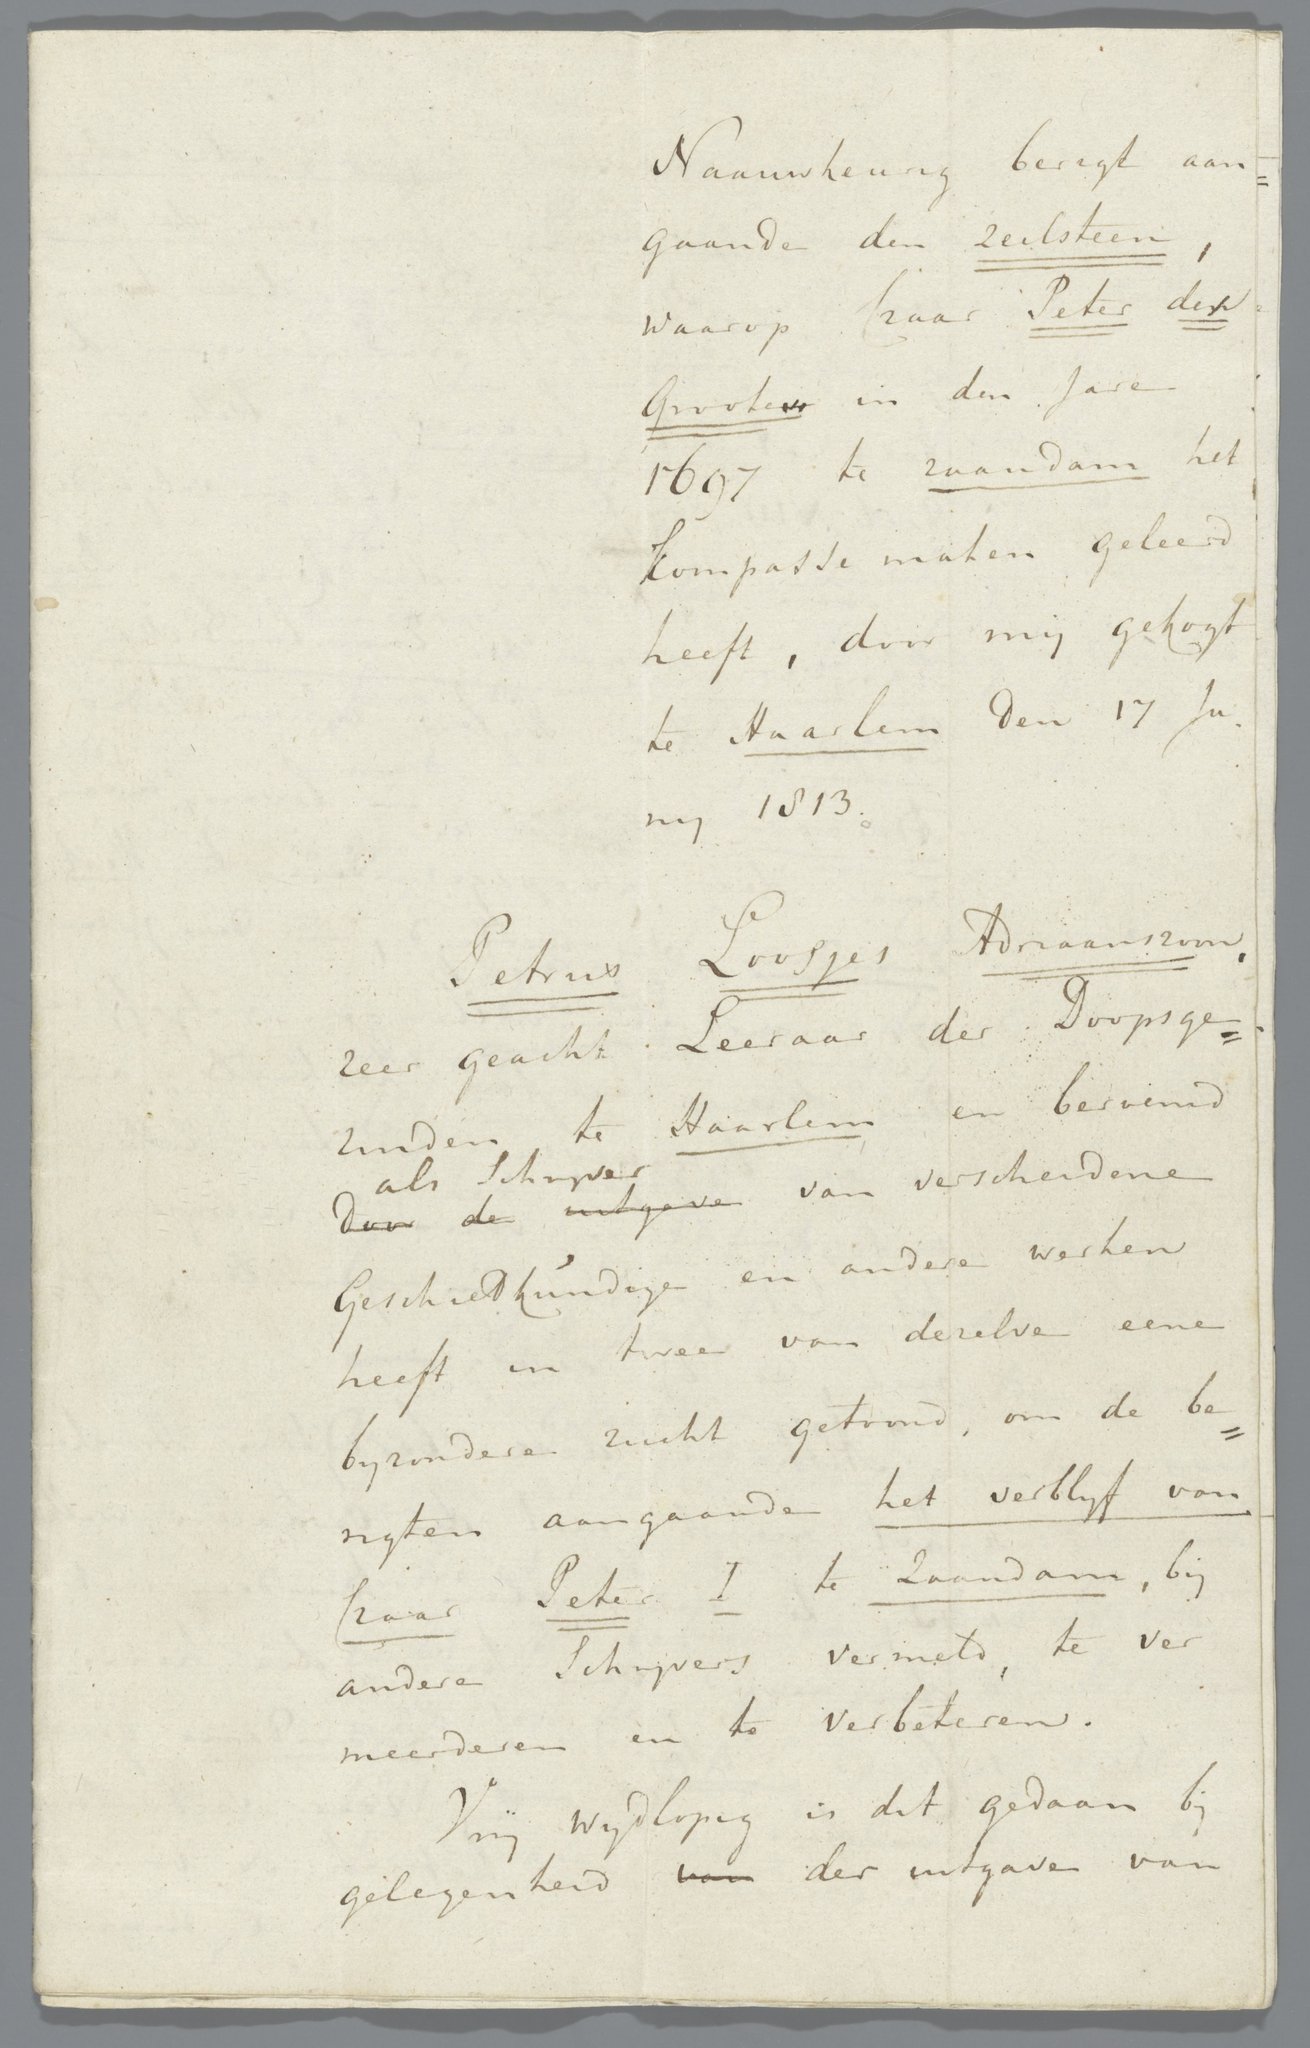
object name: verklaring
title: Verklaring van J. Scheltema betreffende de herkomst van de zeilsteen van Tsaar Peter de Grote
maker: jacobus scheltema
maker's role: geschiedschrijver, letterkundige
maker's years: 1767-1835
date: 1813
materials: ink, lacquer, paper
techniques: printing, folding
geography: zaandam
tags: peter i de grote (tsaar van rusland)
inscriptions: date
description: Handgeschreven verklaring op 3 vellen papier, in elkaar gevouwen zodat er 12 bladzijden ontstaan, waarvan er 10 beschreven zijn. Op pagina10 bij de signatuur een zegelstempel. Opschrift: Naauwkeurig berigt aan / gaande den zeilsteen, / waarop Czaar Peter den / Grooten in den Jaren / 1697 te Zaandam het / kompassemaken geleerd / heeft, (...) Gemerkt; watermerk: krijgsattributen en opschrift: PRO PATRIA / J. HESSELS. Gedateerd: den vyf en twintigsten / van Junij Des jaars achtienhon/derd en dertienen. Gesigneerd.